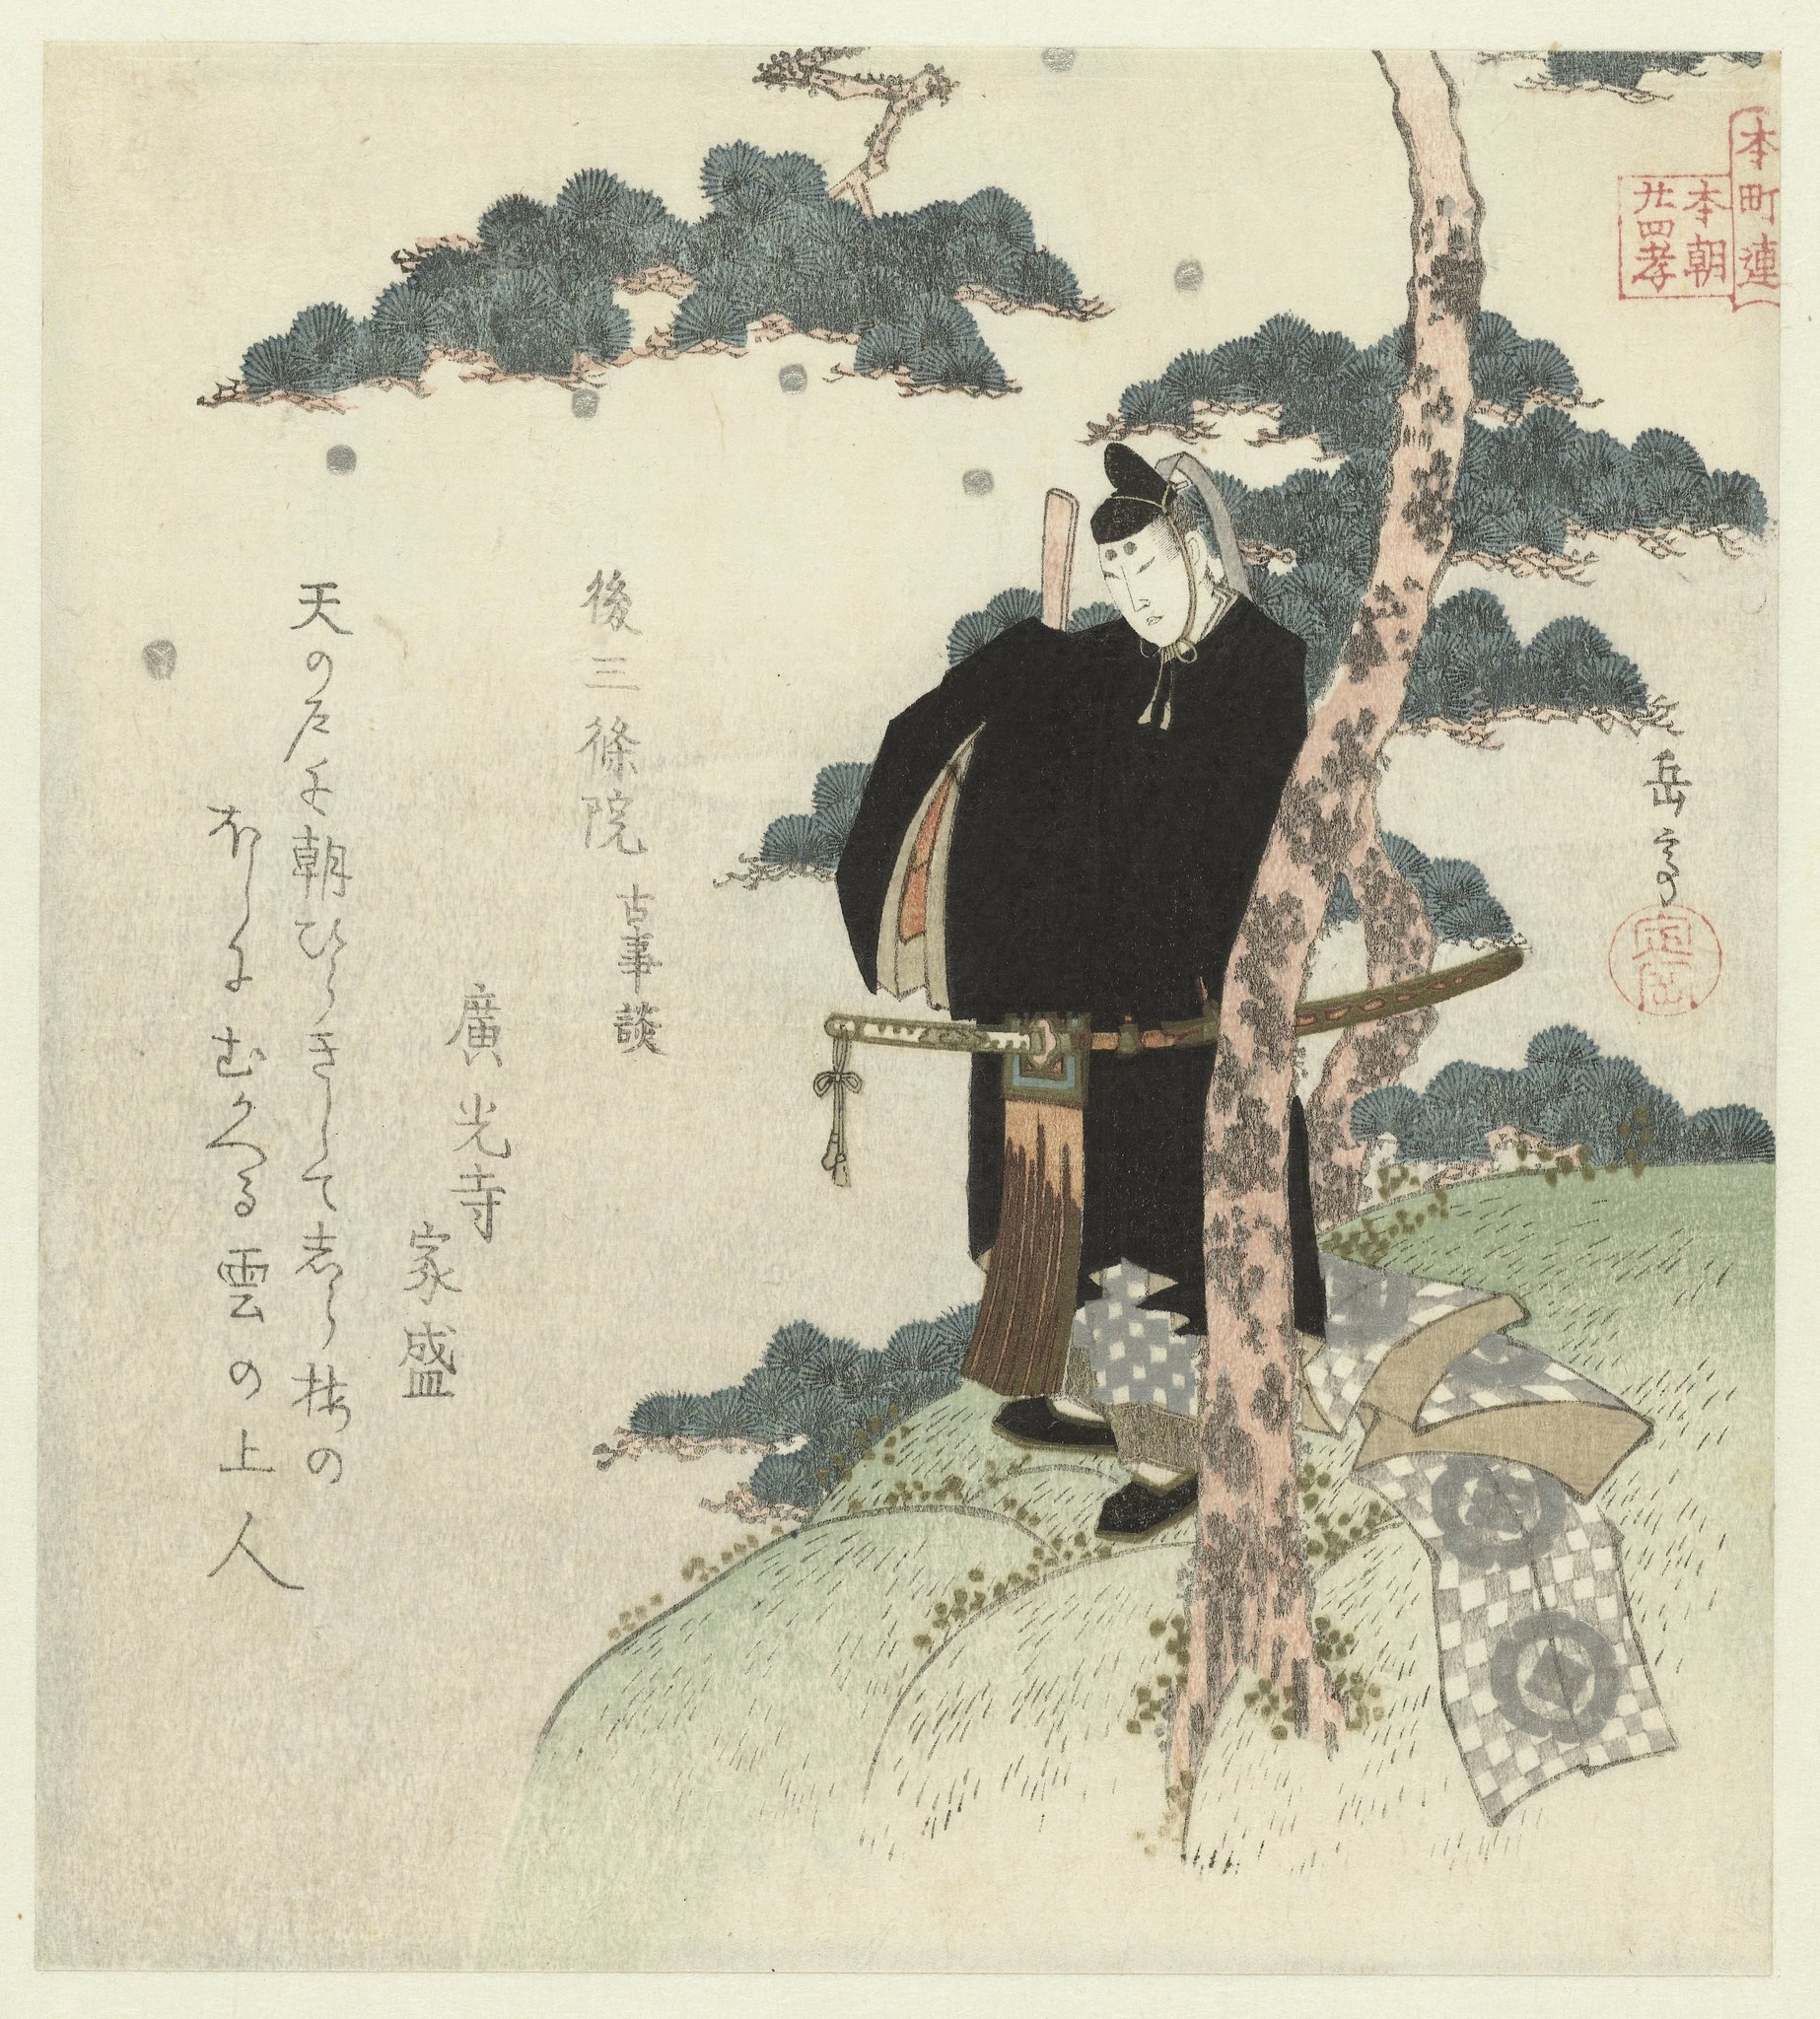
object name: surimono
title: Twenty-four Japanese examples of filial piety for the Honchôren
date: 1821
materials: paper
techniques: blind stamped, woodcut, polish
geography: japan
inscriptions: collector's mark, verso, stamped: Lugt 2228, collector's mark, passe-partout, bottom left, printed: B with two mountains in a circle., collector's mark, passe-partout, bottom left, printed: JABdH with a rooster.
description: Een surimono is een luxe uitgevoerde prent waarop beeld met één of meerdere gedichten gecombineerd is. Bij het drukken van een surimono werd vaak gebruik gemaakt van dikker papier, blinddruk en metaal pigmenten, zoals koper- en zilverpoeder. De prenten werden vaak in opdracht van dichters gemaakt en als exclusief geschenk aan vrienden en relaties gegeven.